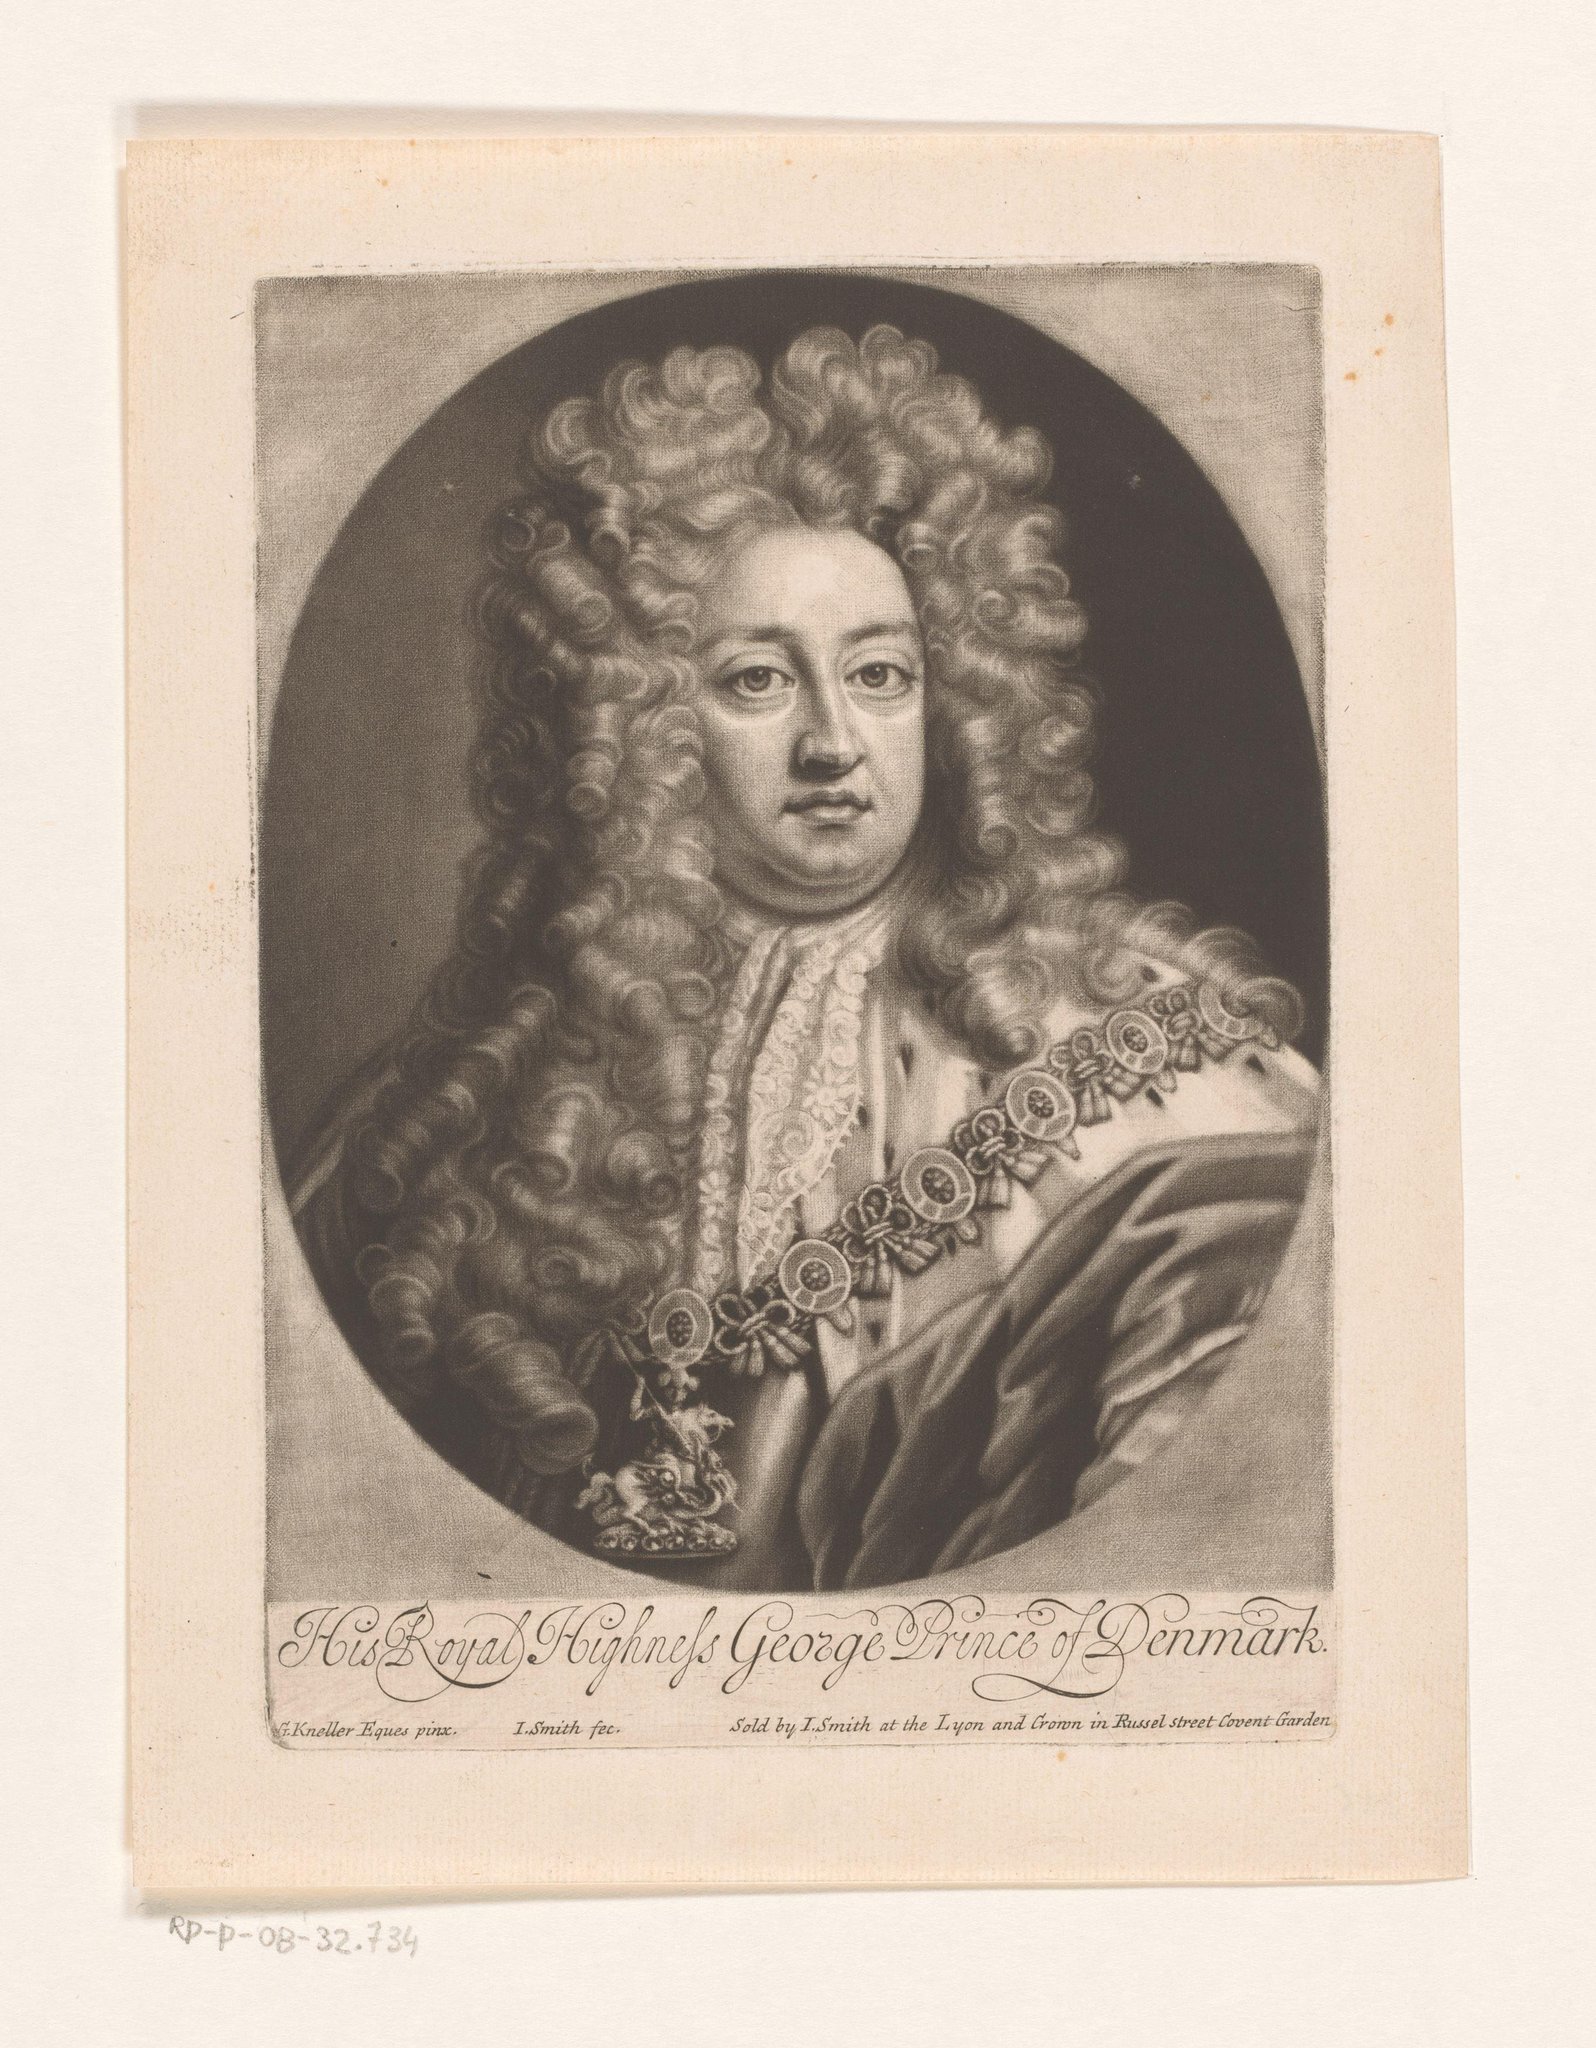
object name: print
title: Portret van George, prins van Denemarken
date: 1702-1742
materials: paper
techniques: mezzotint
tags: george (prins van denemarken), prince, historical persons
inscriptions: collector's mark: Lugt 240